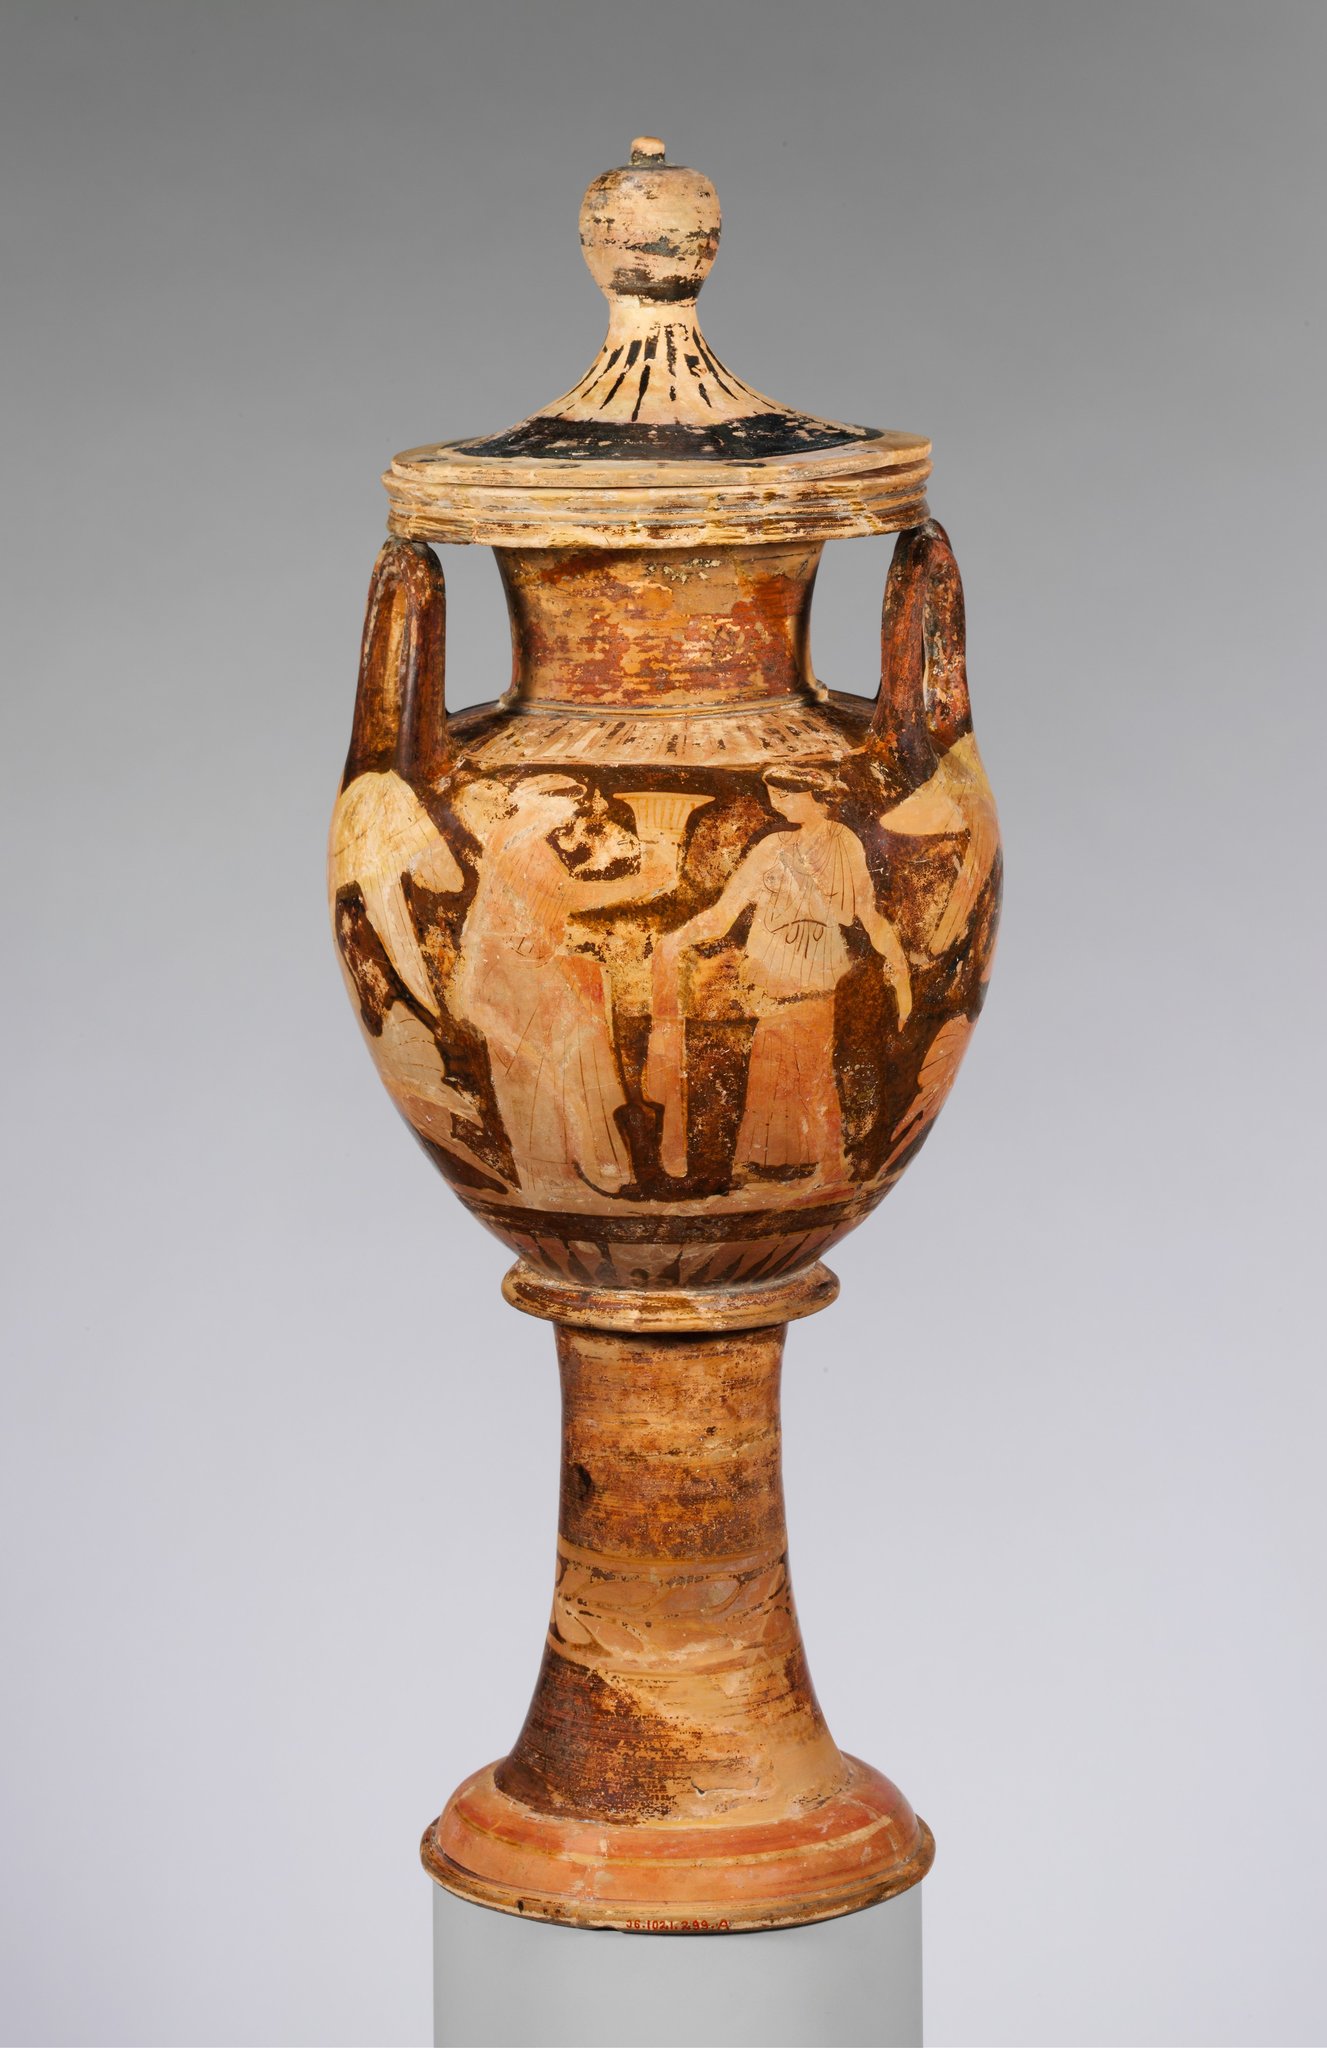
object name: lebes gamikos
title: Terracotta lebes gamikos (round-bottomed bowl with handles and stand used in weddings)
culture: greek, attic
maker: painter of london 1923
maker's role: artist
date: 440-430 BCE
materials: terracotta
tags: women,nike